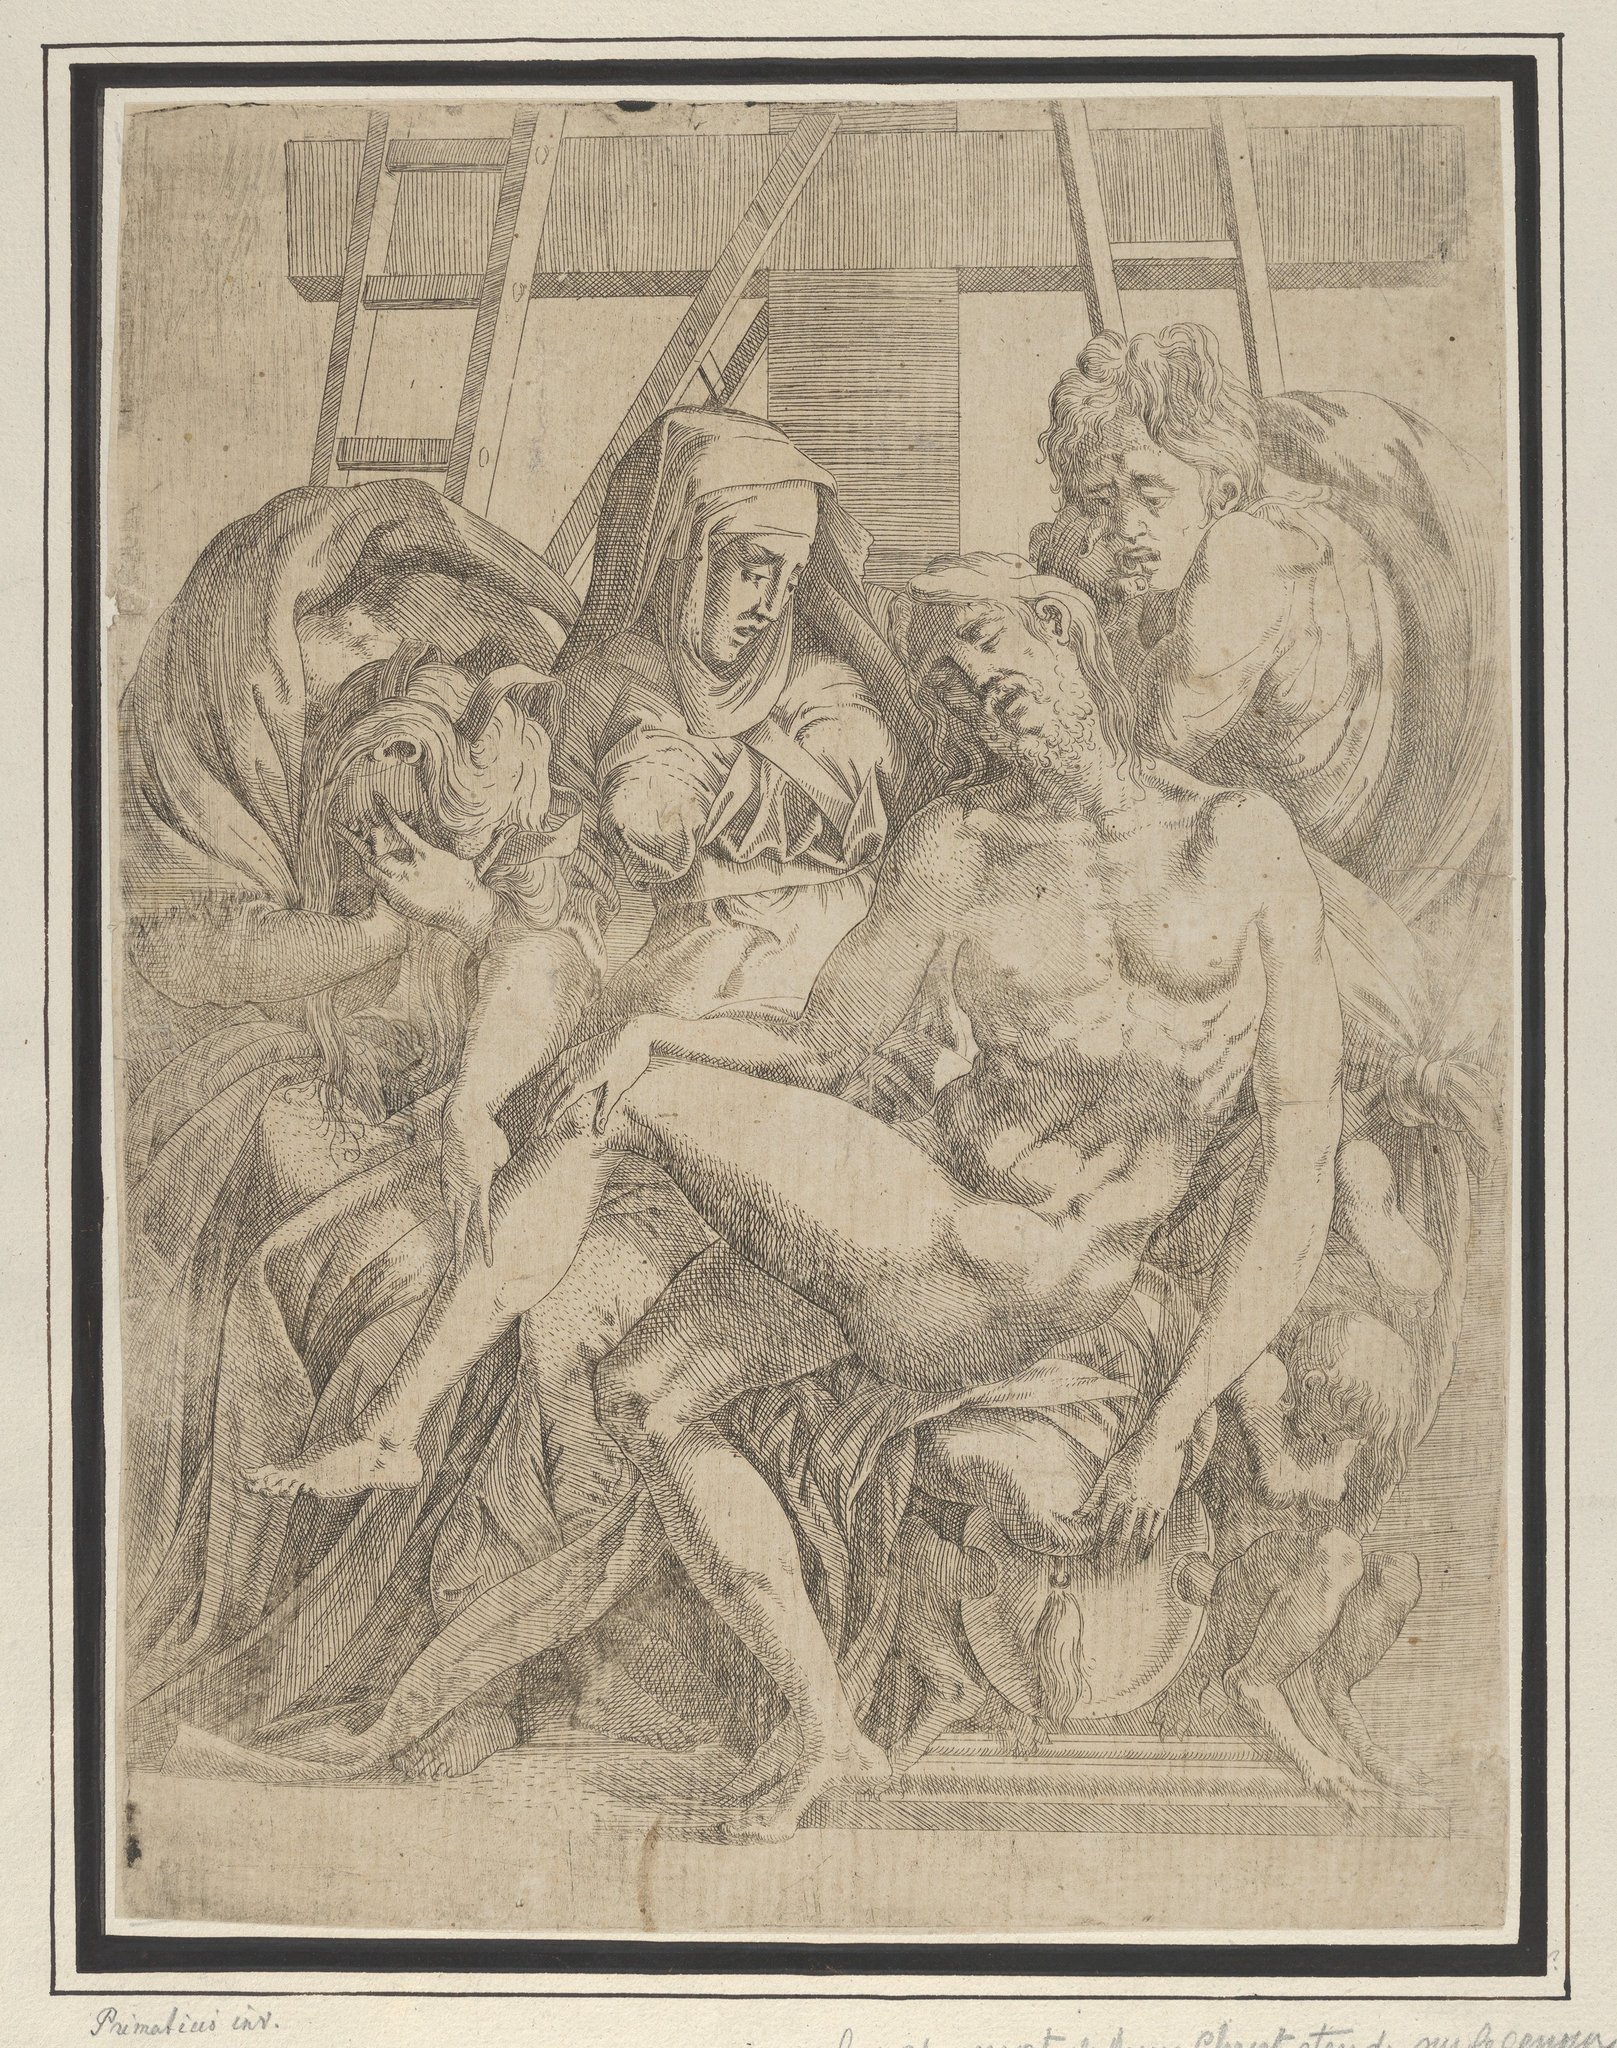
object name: print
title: Pietà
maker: antonio fantuzzi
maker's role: artist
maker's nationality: italian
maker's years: 1537-1545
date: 1540-1545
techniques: etching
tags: male nudes,women